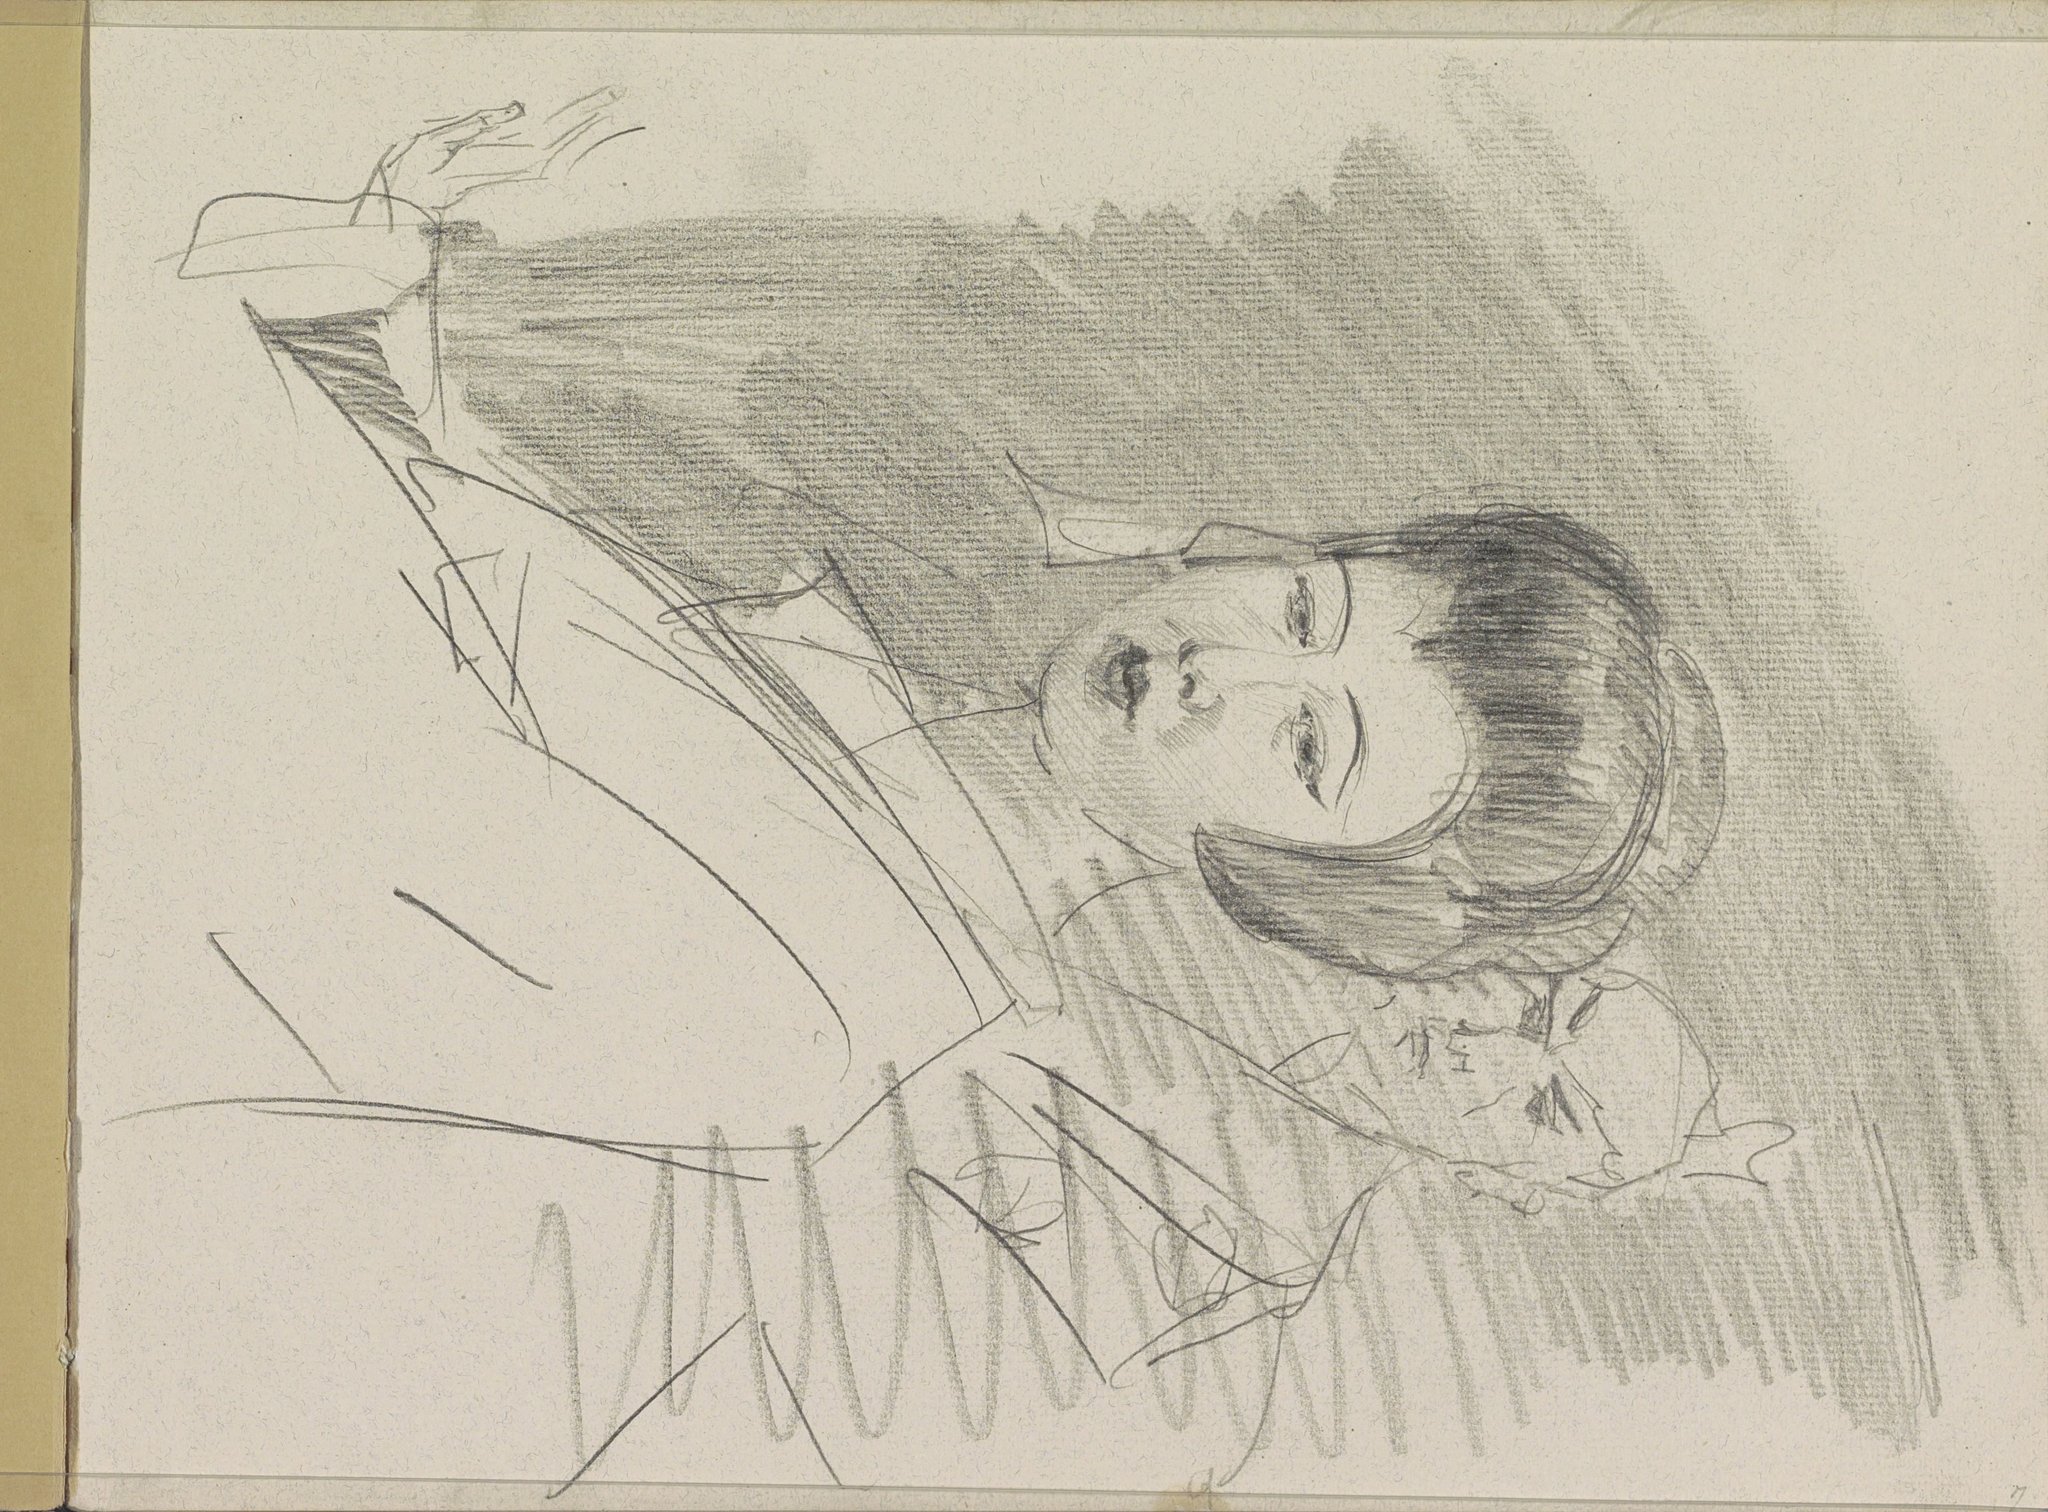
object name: sketchbook leaf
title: Japanse vrouw en man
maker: isaac israels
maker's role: draughtsman, painter, print maker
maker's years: 1865-1934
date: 1875-1934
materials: paper, pencil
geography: the hague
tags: adult woman, adult man, japanese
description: De vrouw is mogelijk een geisha. Blad 7 recto uit schetsboek IV met 27 bladen.